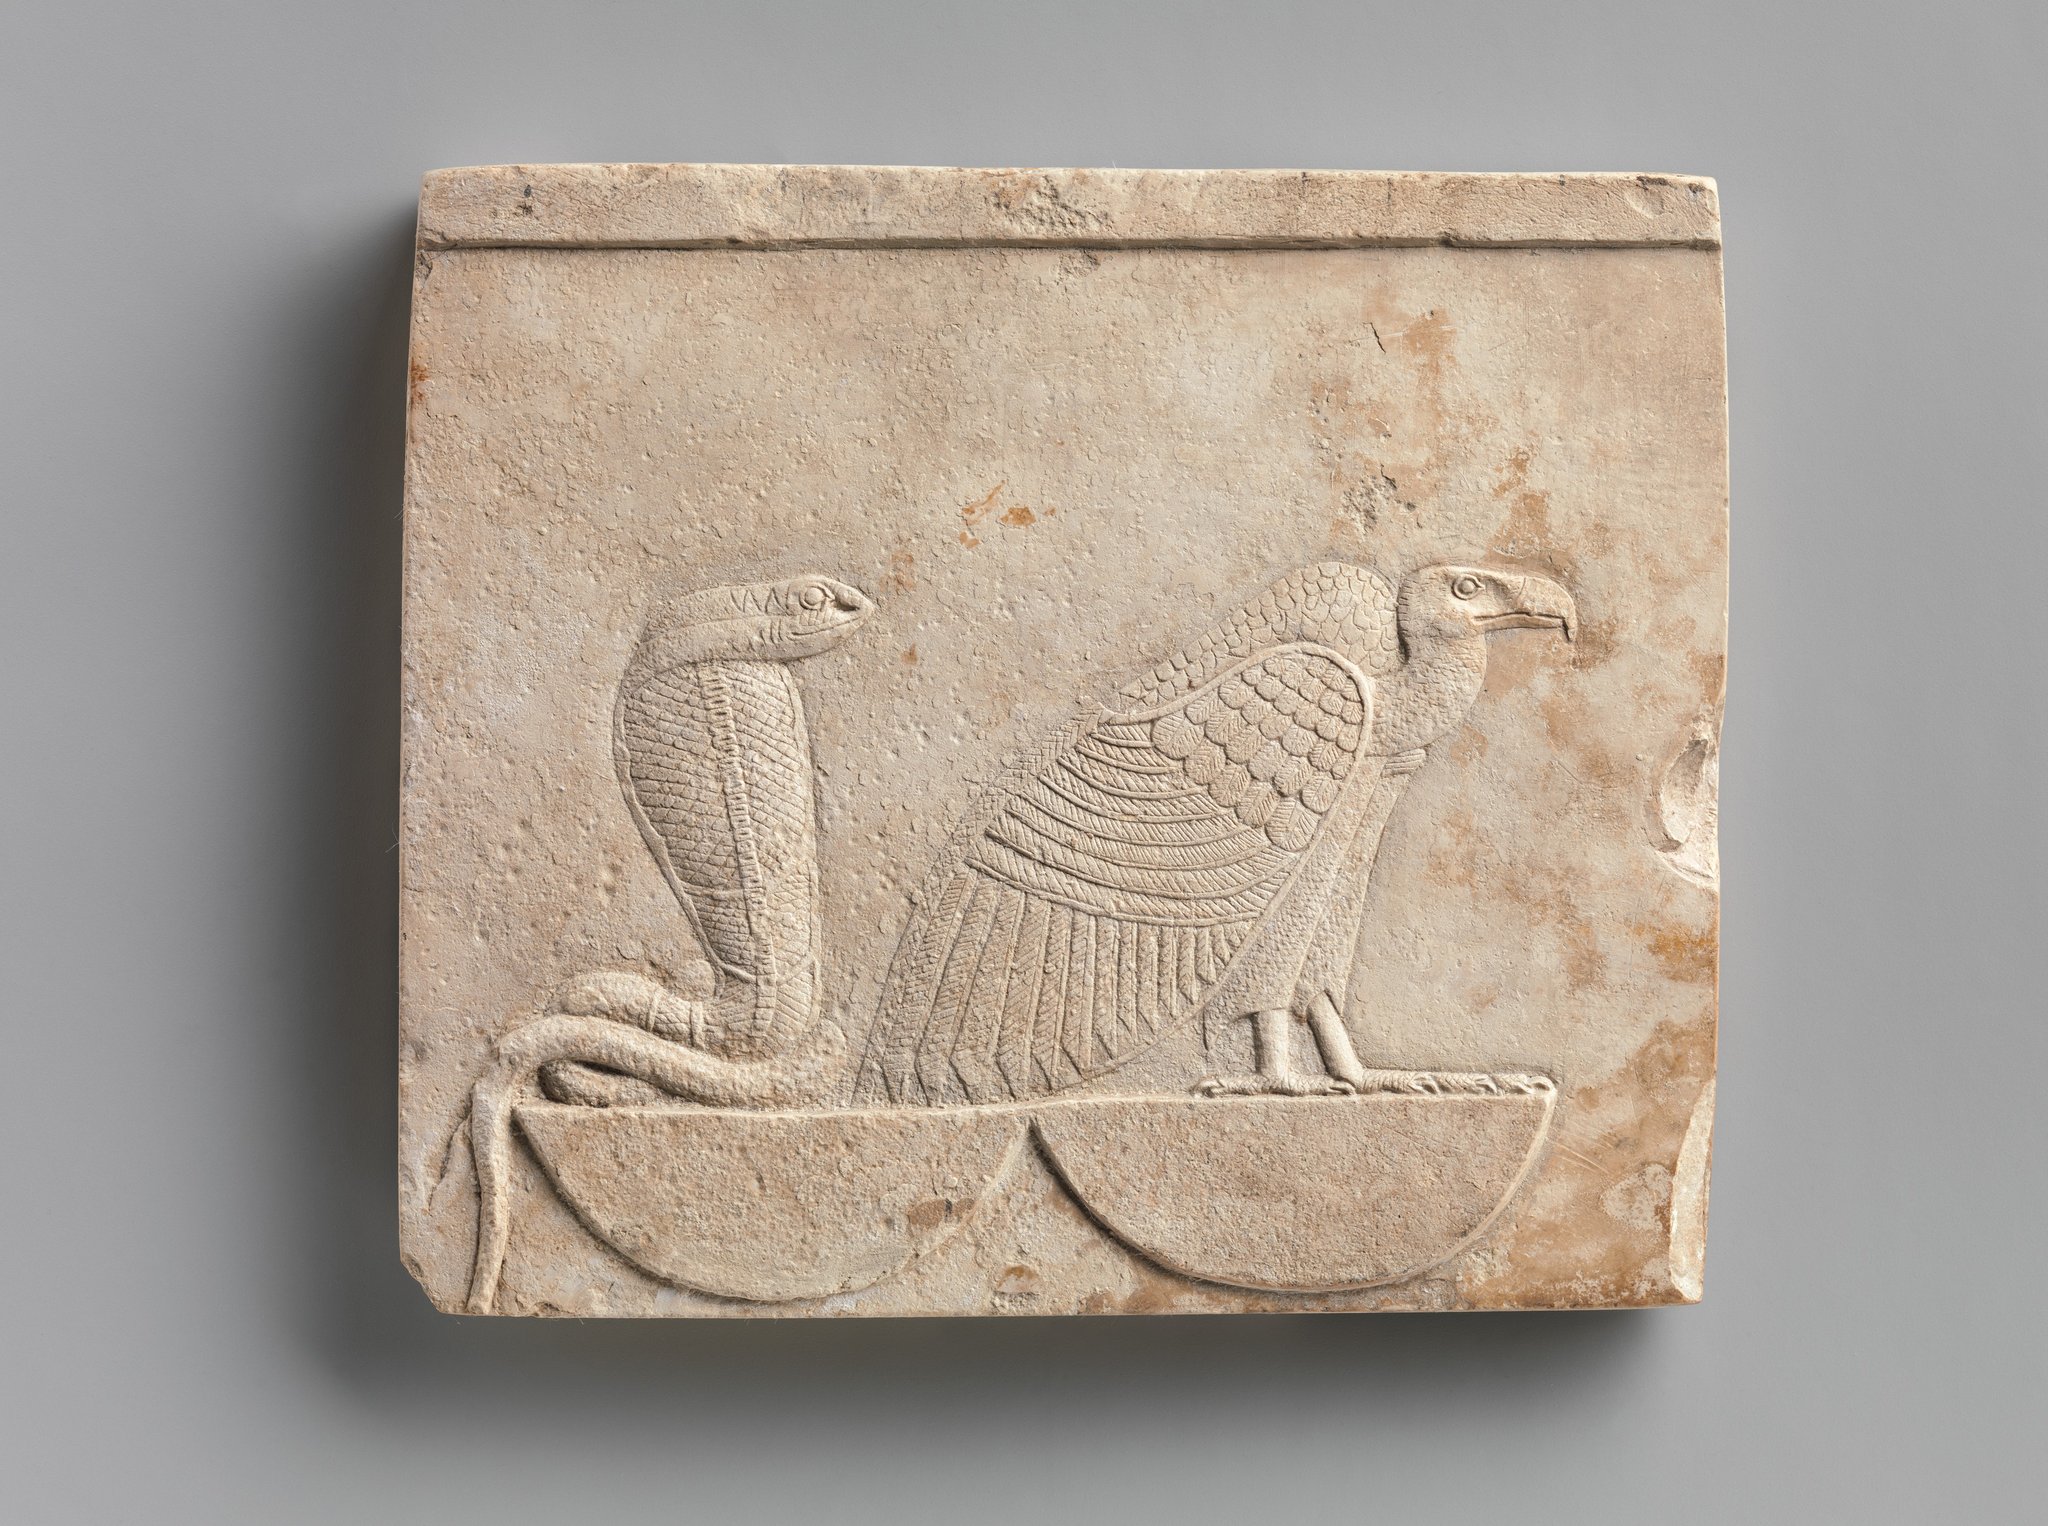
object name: sculptor's model votive, vulture and cobra, falcon opposite side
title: Relief plaque with Wadjet and Nekhbet, the "Two Ladies"; falcon on opposite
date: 400-30 BCE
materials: limestone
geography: egypt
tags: birds,falcons,snakes